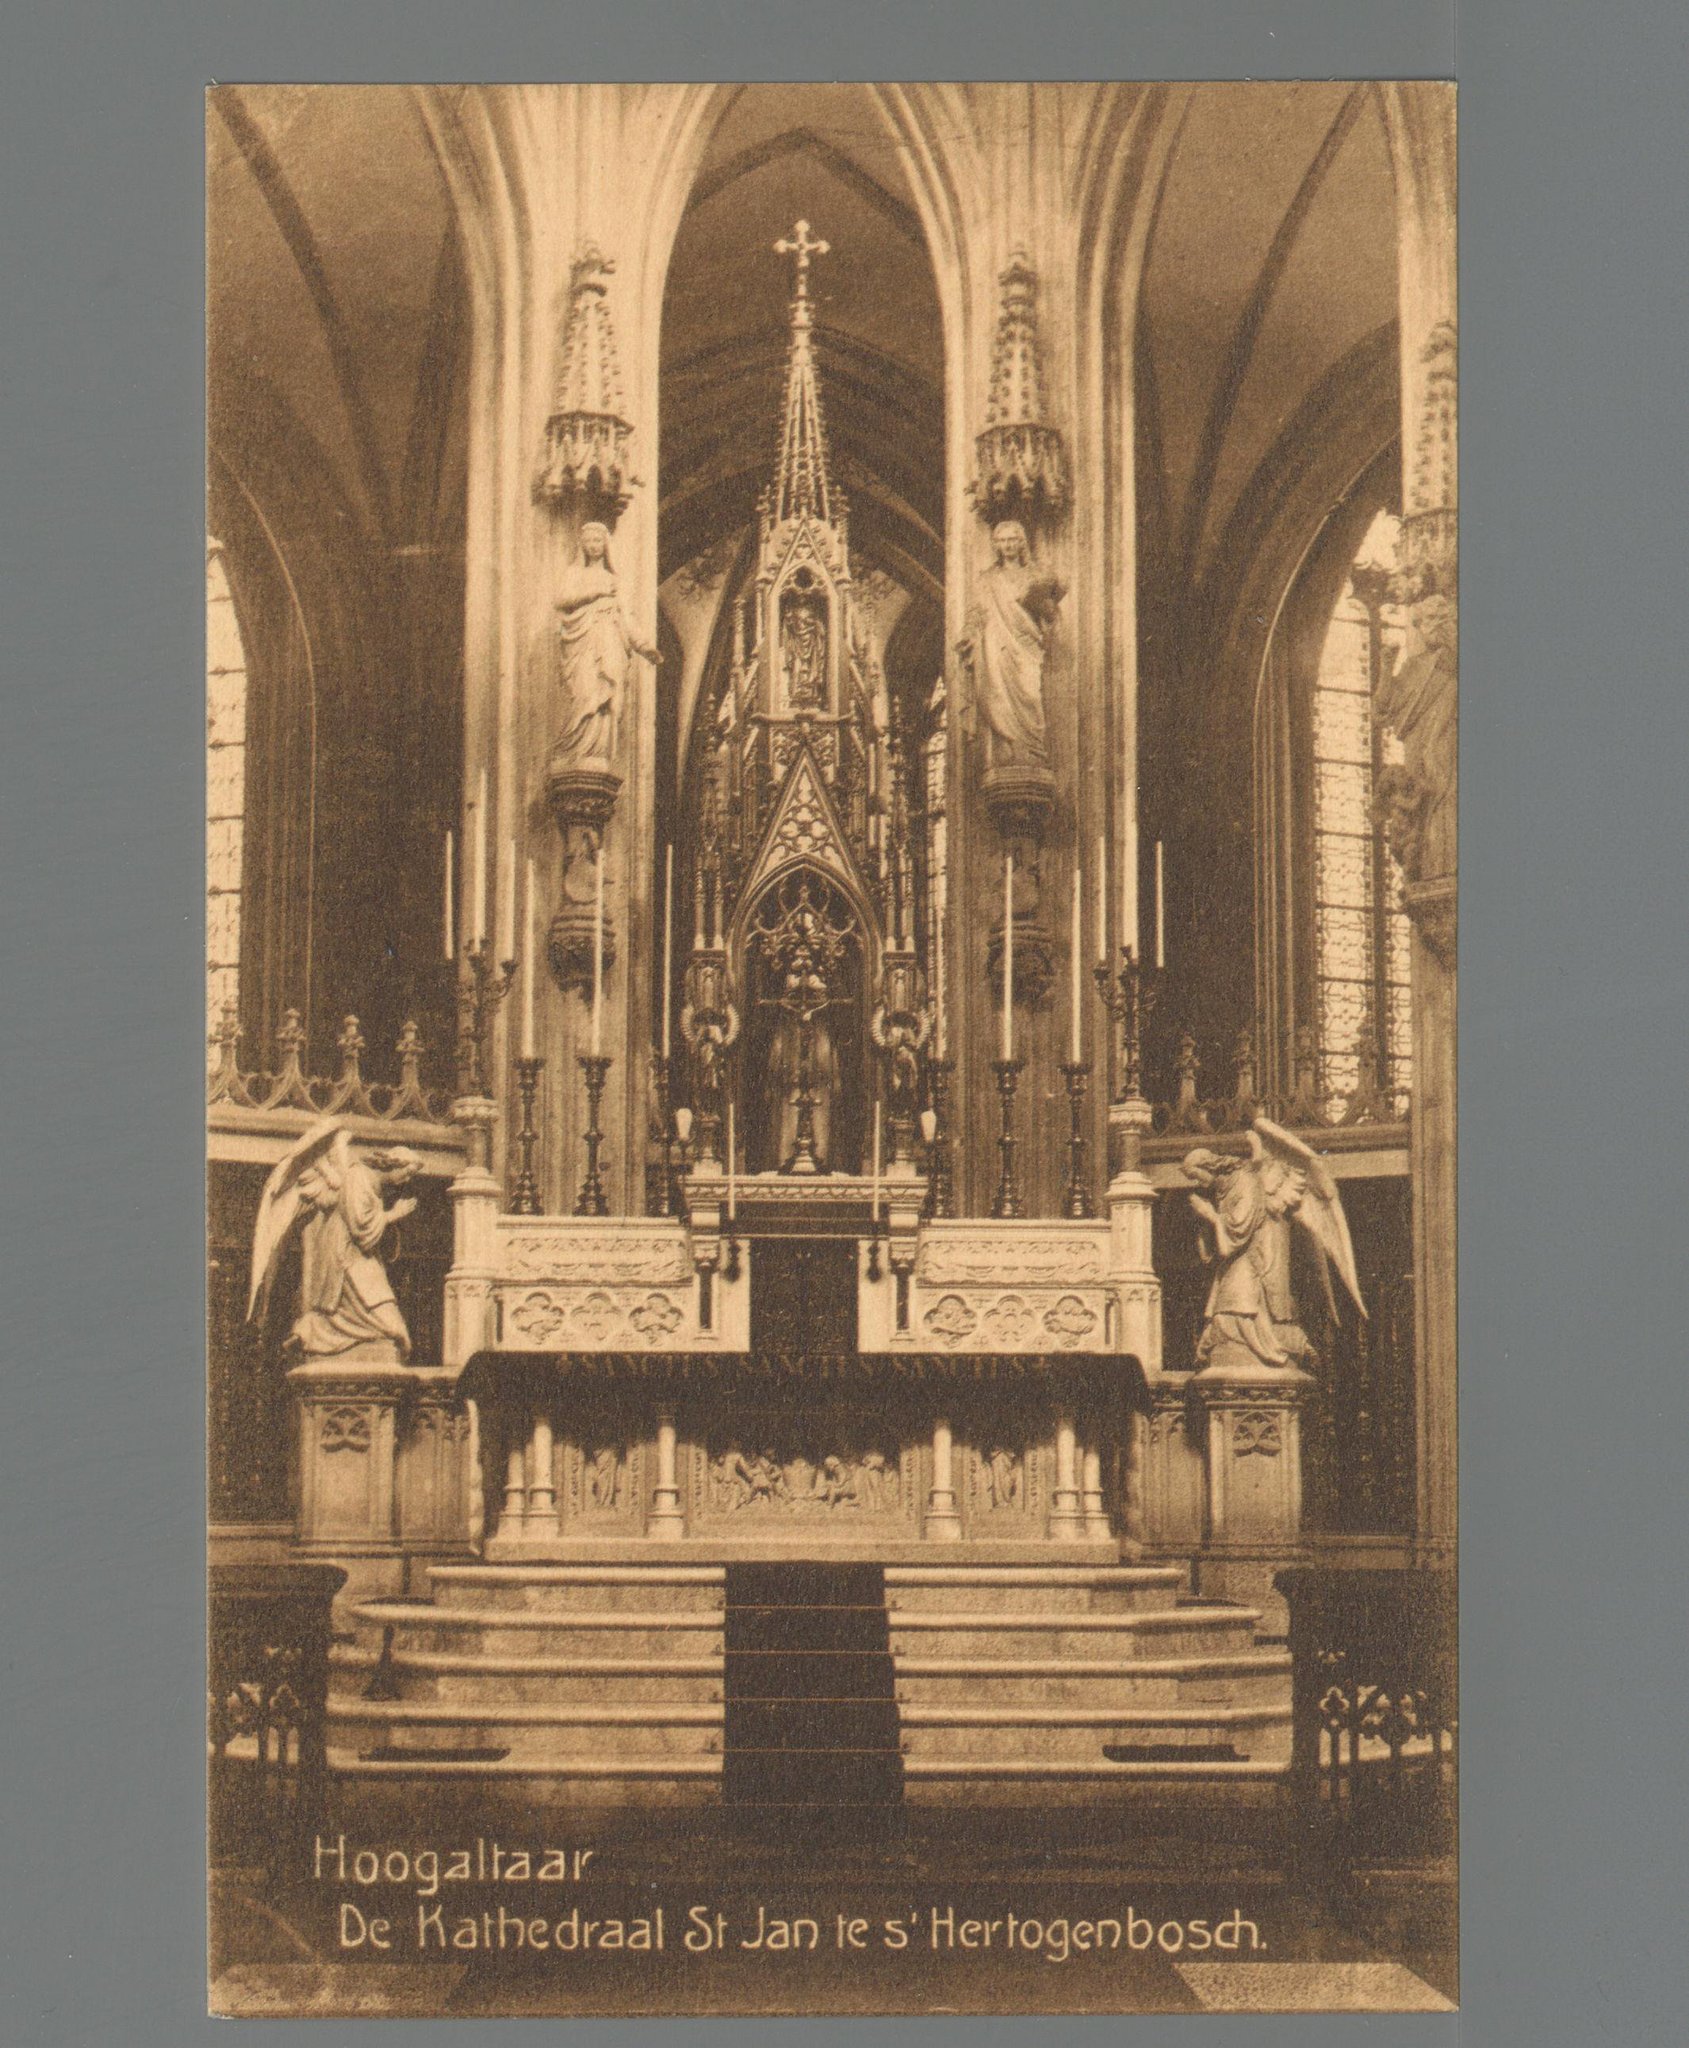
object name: ansichtkaart, prentbriefkaart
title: Hoogaltaar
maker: Anonymous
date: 1905-1930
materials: cardboard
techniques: photograph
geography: den bosch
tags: interior of church, altar with altar-piece